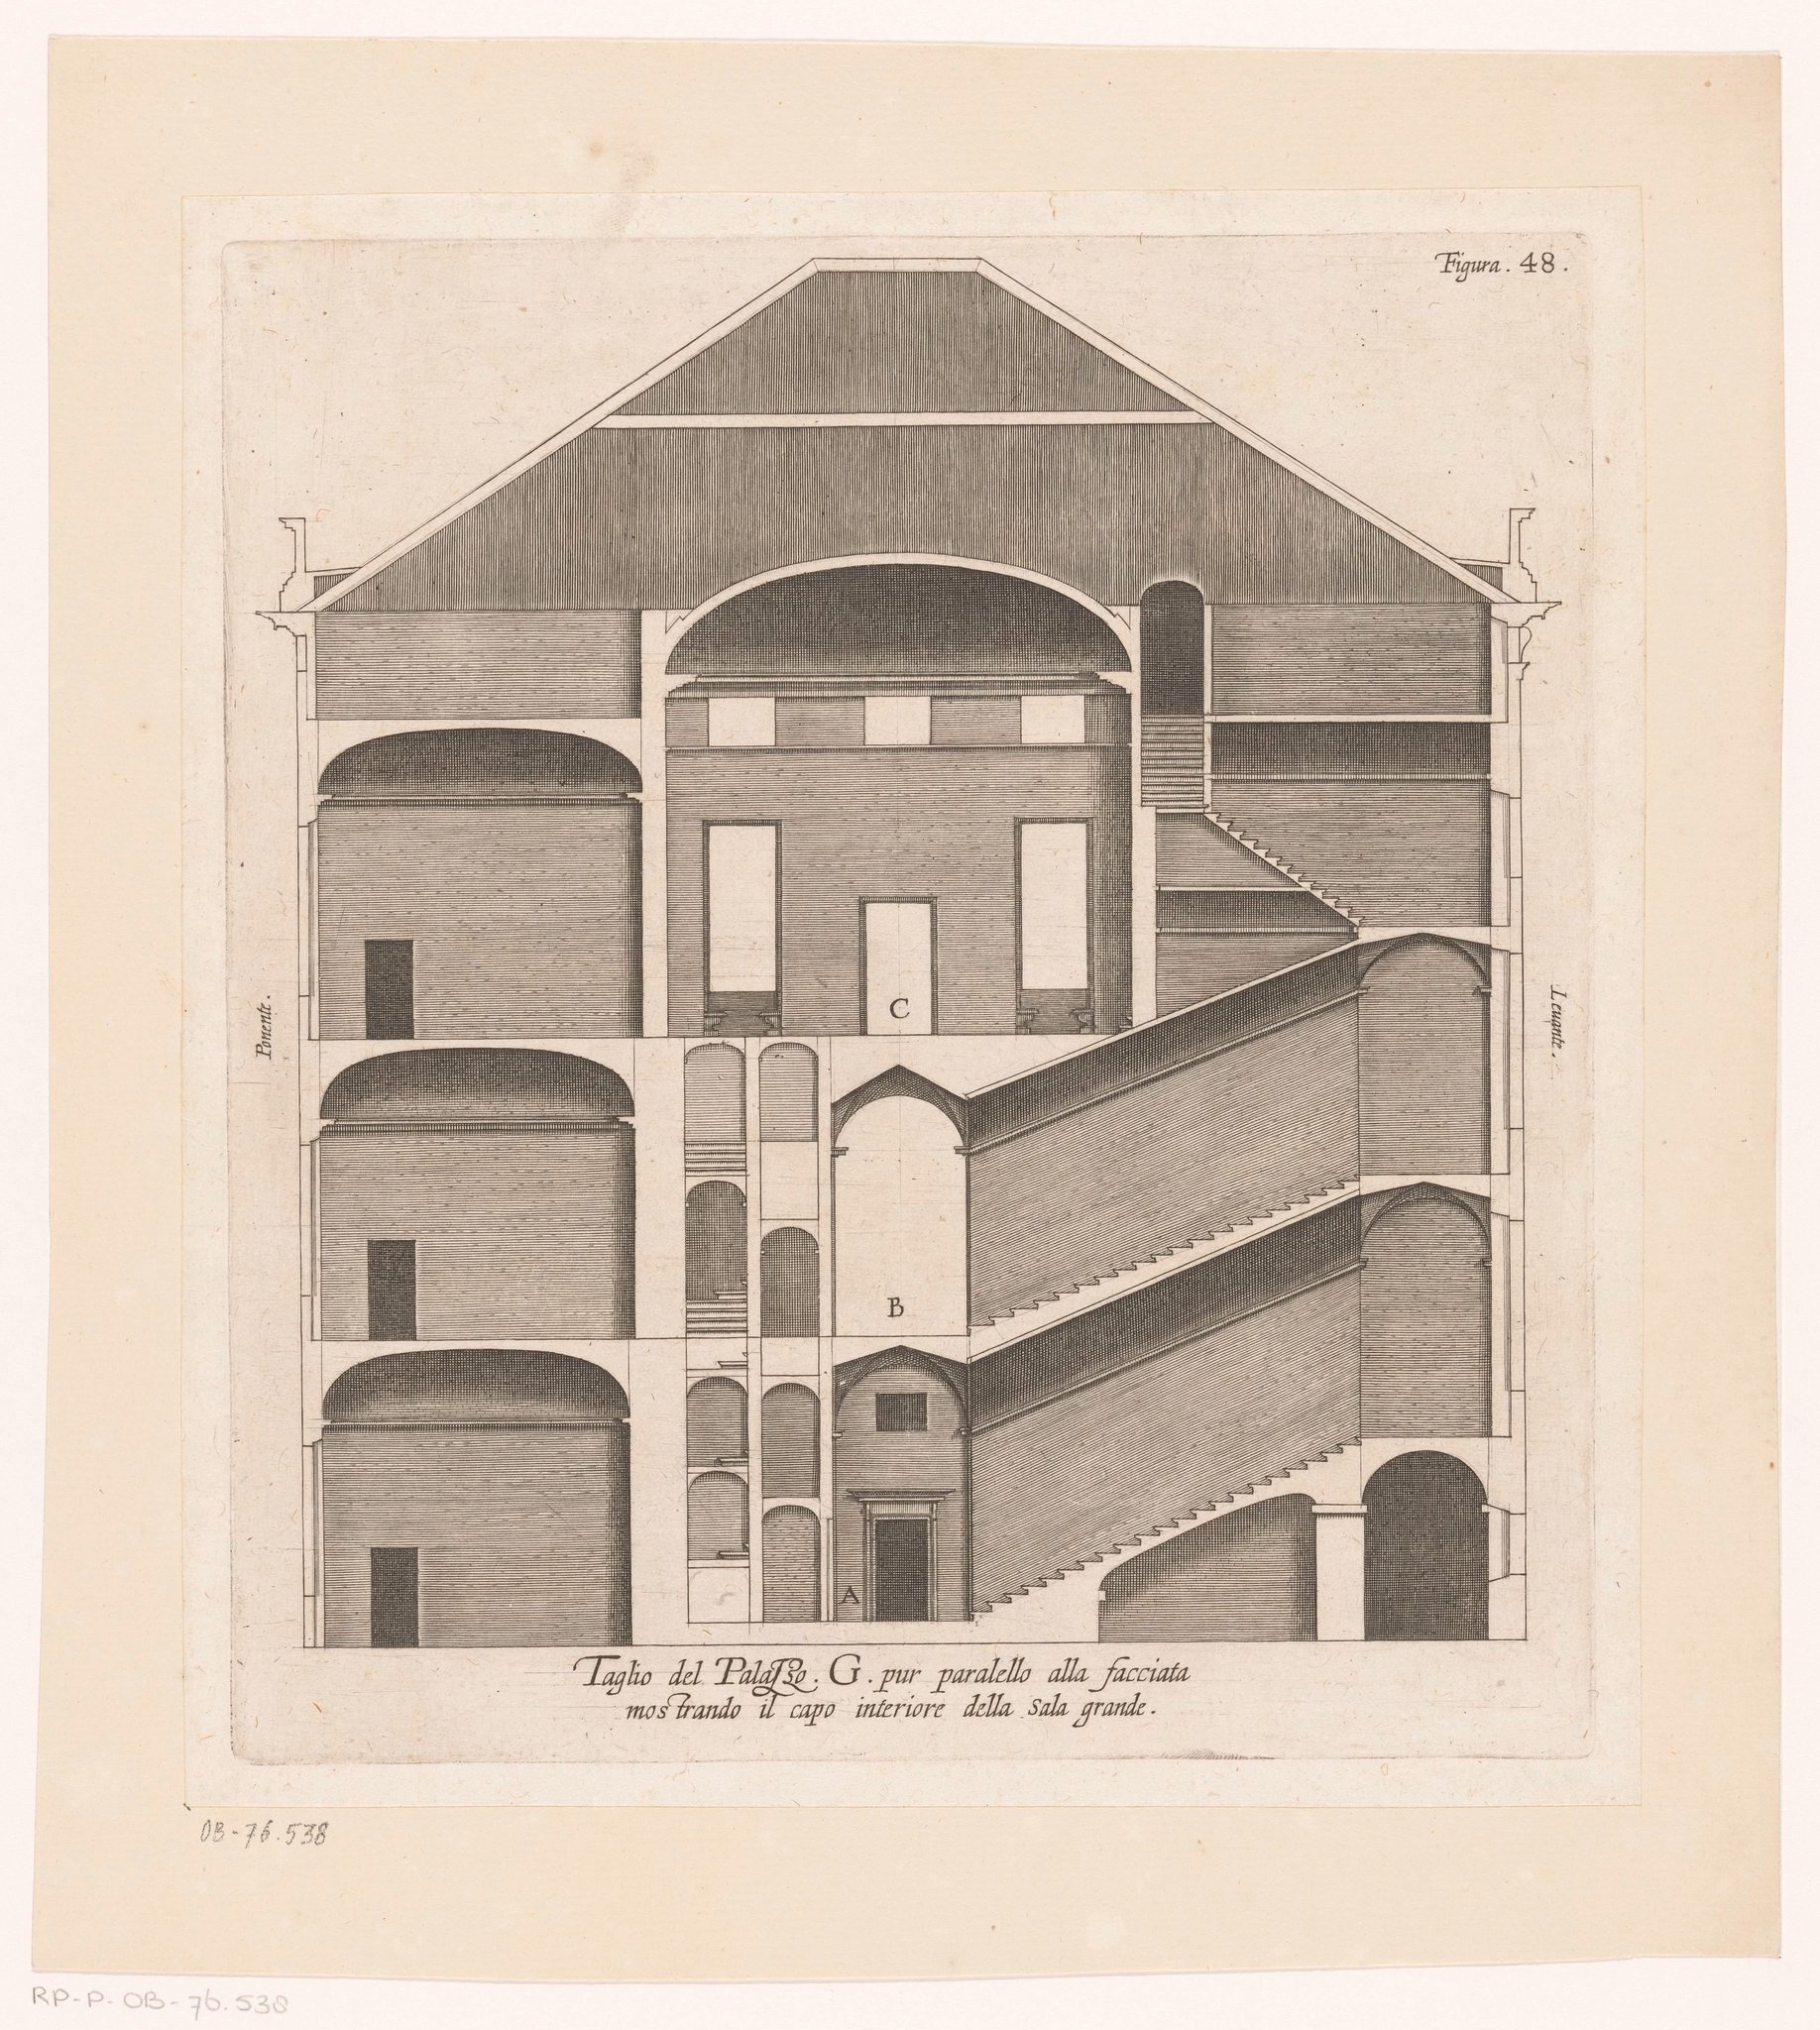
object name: print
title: Taglio del Palazzo. G. pur paralello alla facciata mostrando il capo interiore della sala grande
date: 1622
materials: paper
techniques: engraving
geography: antwerp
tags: hôtel, i.e. small palace in city - aa - civic architecture: inside, section ~ architectural design or model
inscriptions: collector's mark: Lugt 240